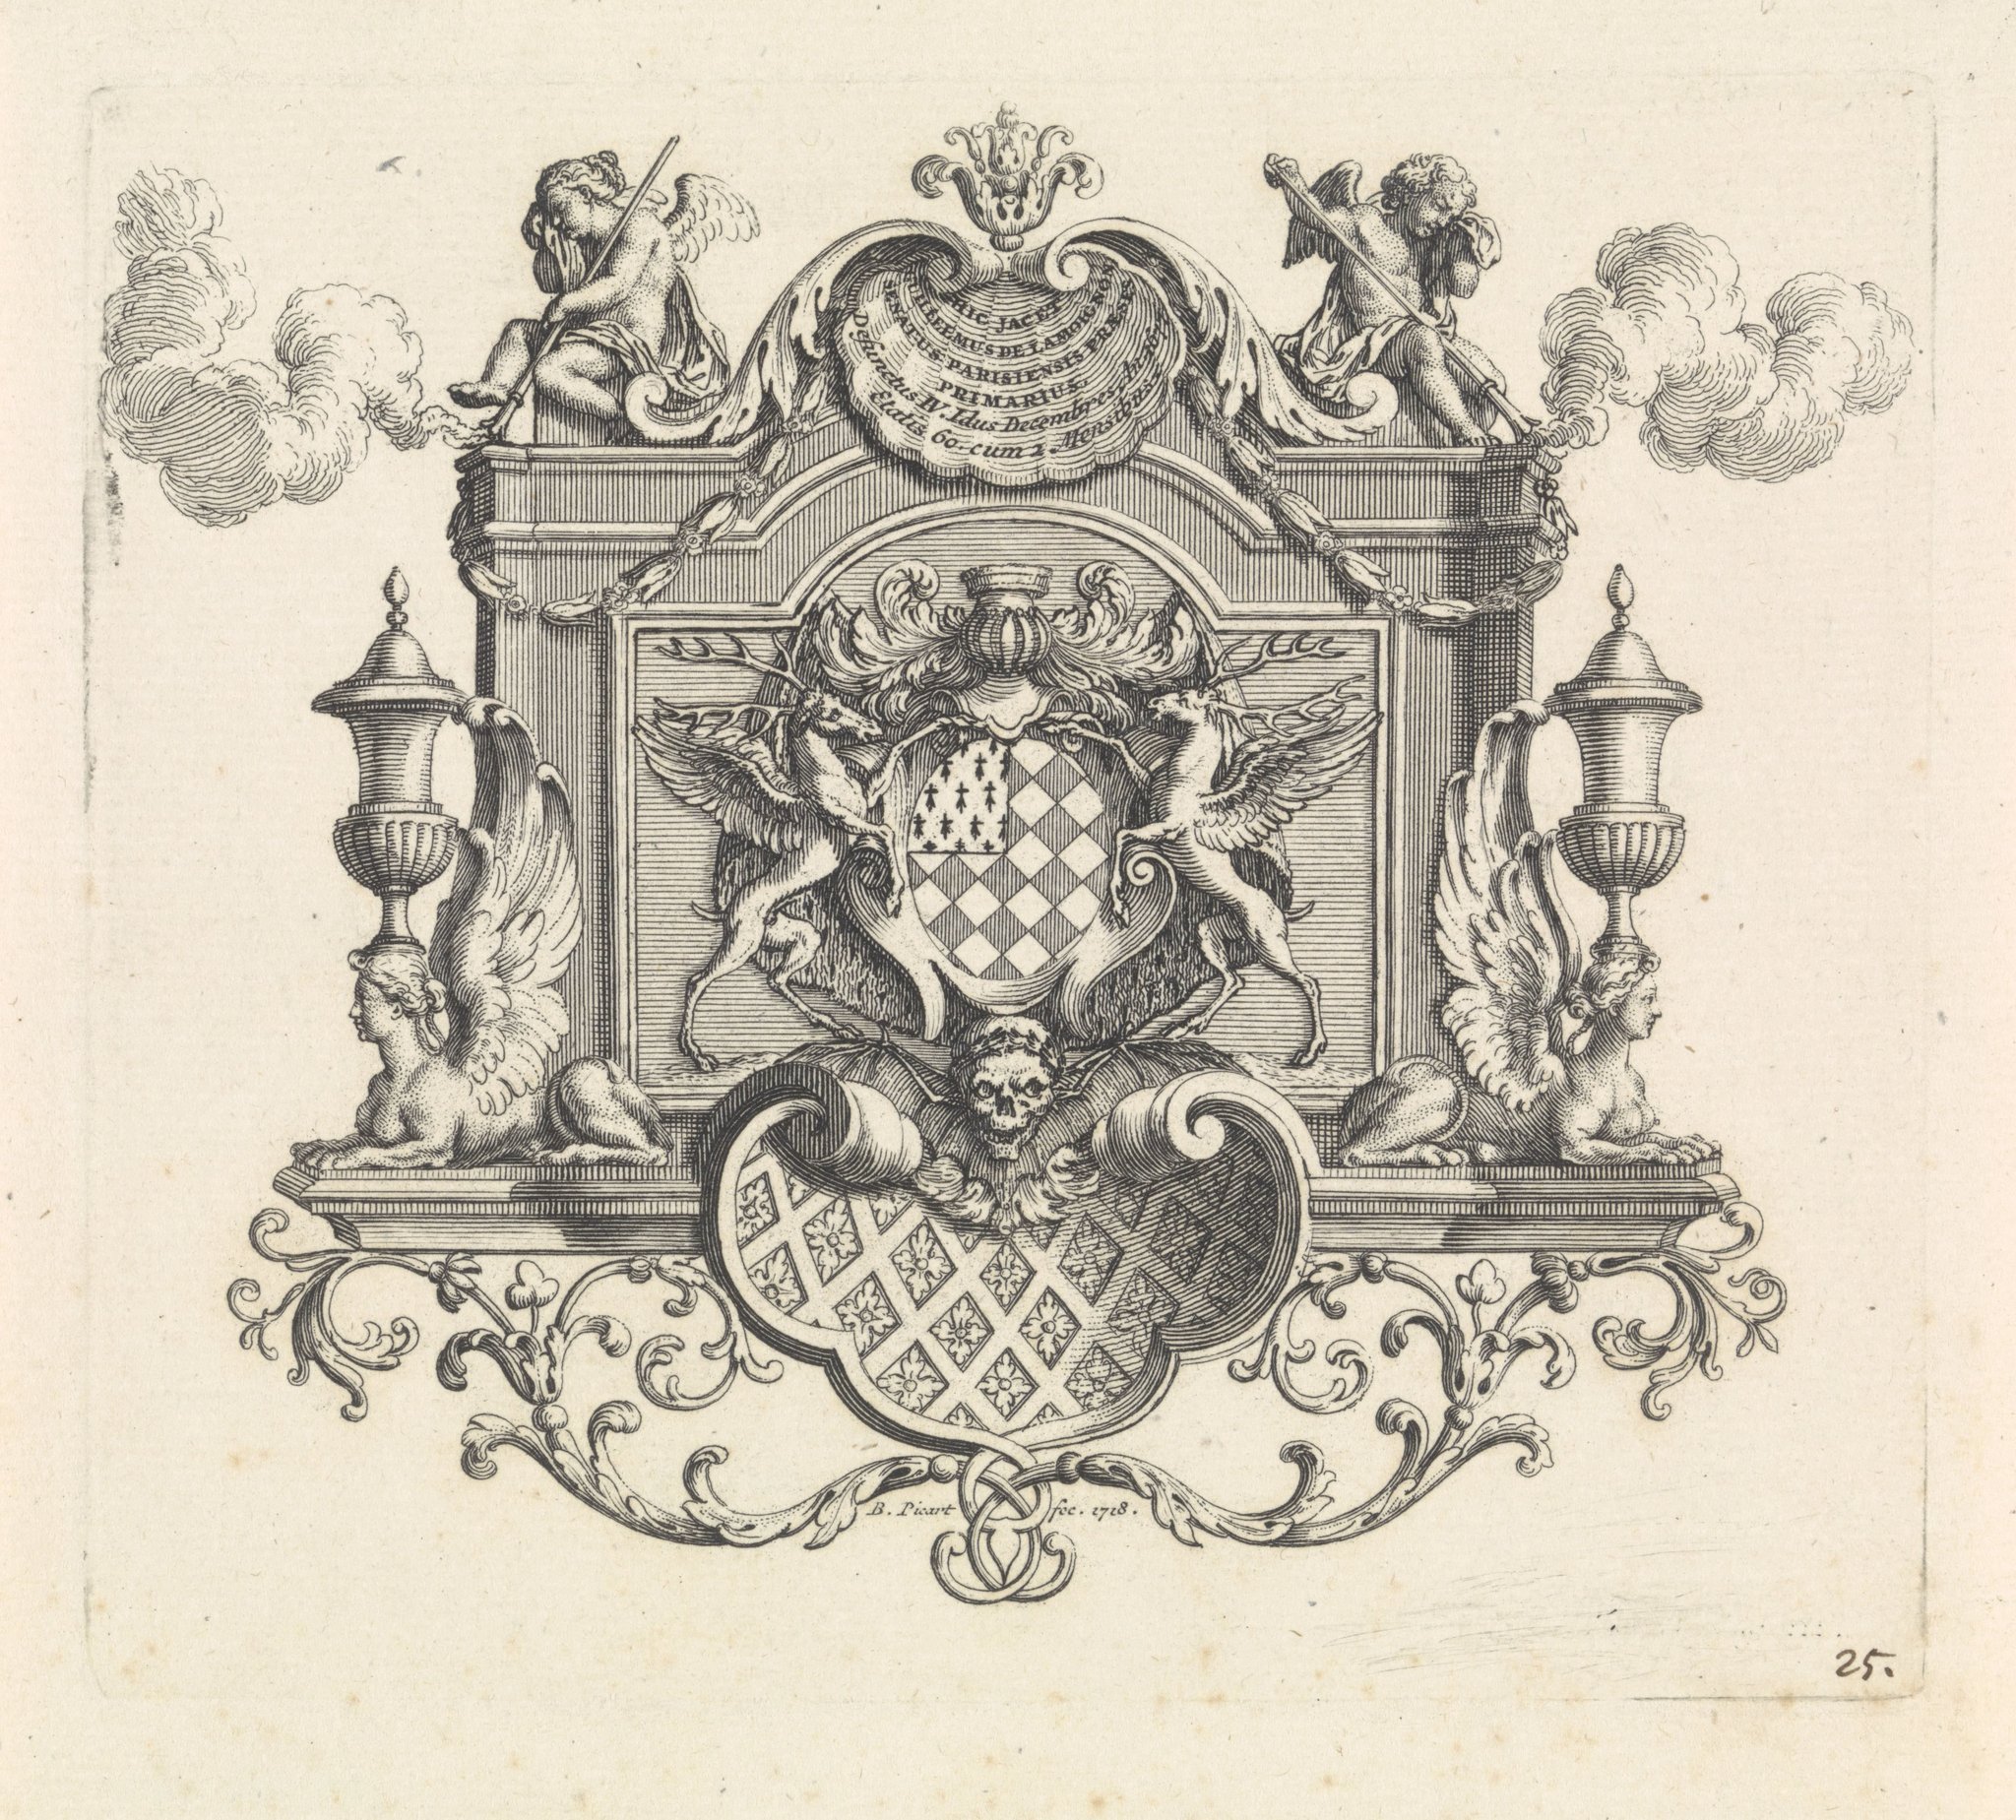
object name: print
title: Gedenkteken voor Guillaume de Lamoignon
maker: bernard picart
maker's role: draughtsman, print maker, publisher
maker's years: 1673-1733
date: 1718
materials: paper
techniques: engraving, etching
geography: amsterdam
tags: paris, torch - bb - torch held upside down (+ extinguishing; extinguished light, lamp, candle), ornaments ~ art, mourning the dead, armorial bearing, heraldry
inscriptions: collector's mark: Lugt 2228, number: ‘25.’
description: Een gedenkteken voor Guillaume de Lamoignon met in het midden zijn wapenschild. Bovenop het gedenkteken zitten twee treurende putti met uitgedoofde fakkels.